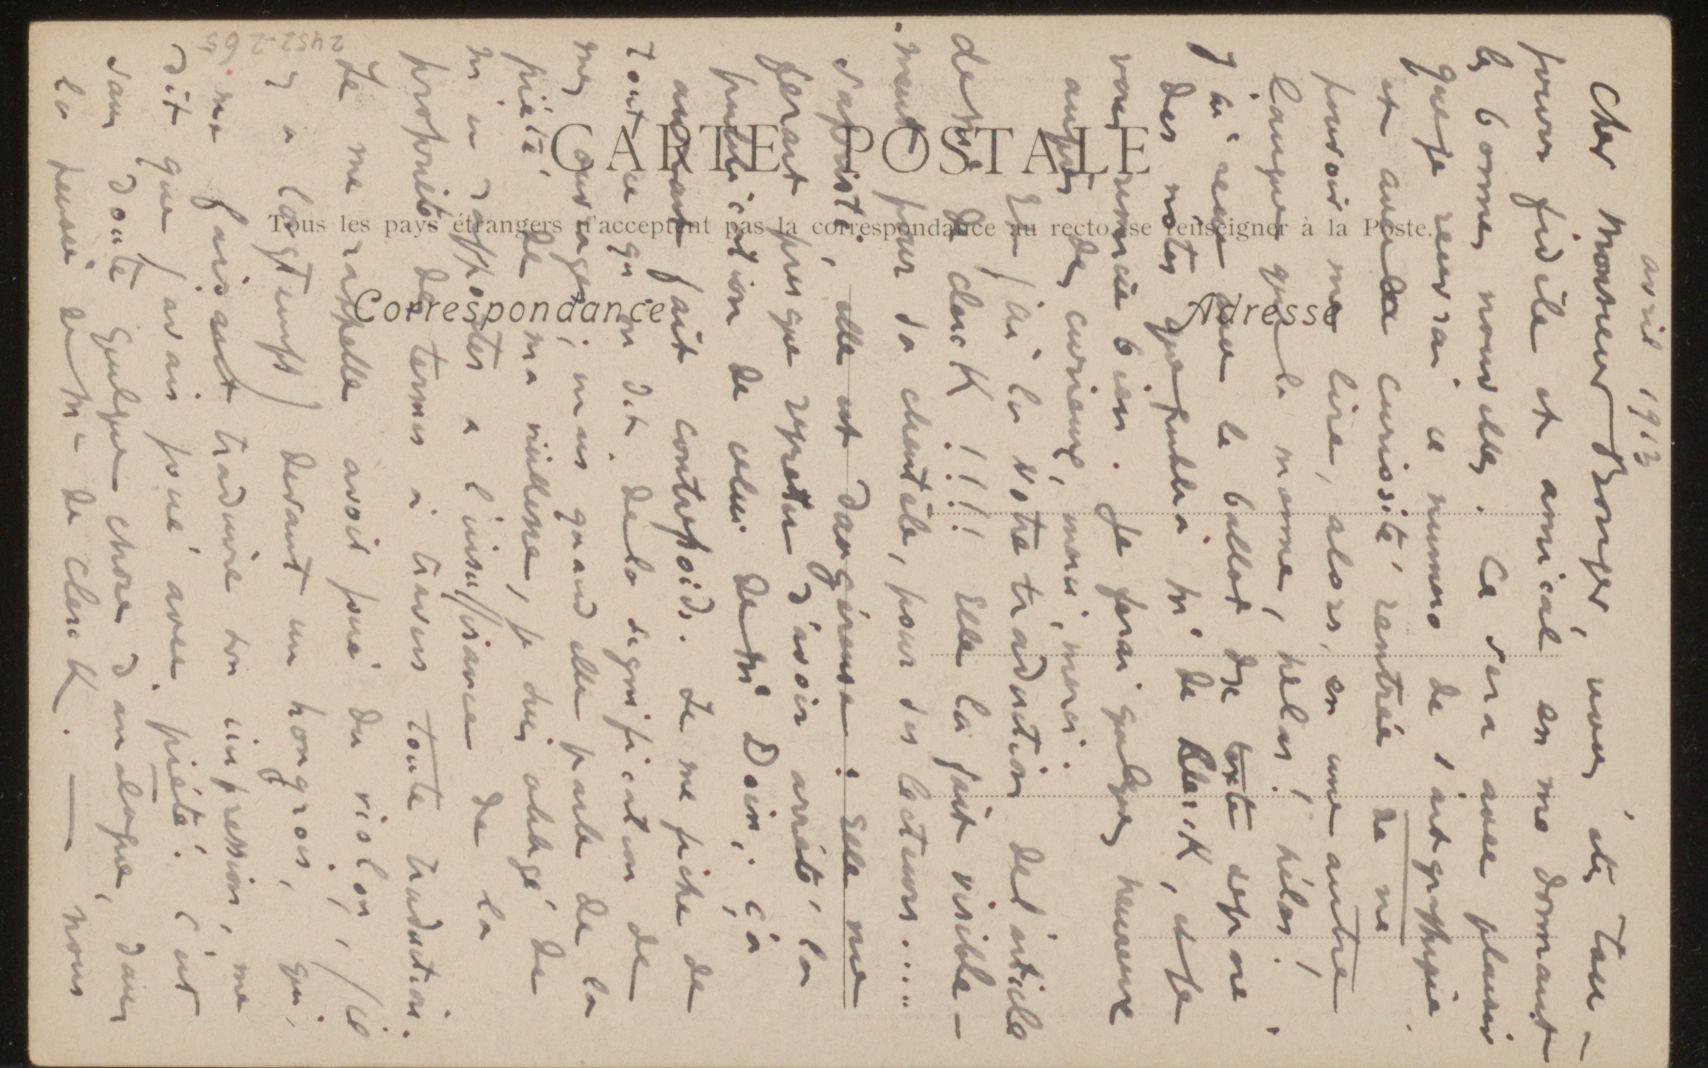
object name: ansichtkaart, prentbriefkaart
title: Prentbriefkaart aan Andries Bonger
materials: cardboard, ink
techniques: pen, writing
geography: paris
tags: amsterdam, andries bonger, drawing, applied arts, arts and crafts; industrial design, exhibition ~ art, ghent